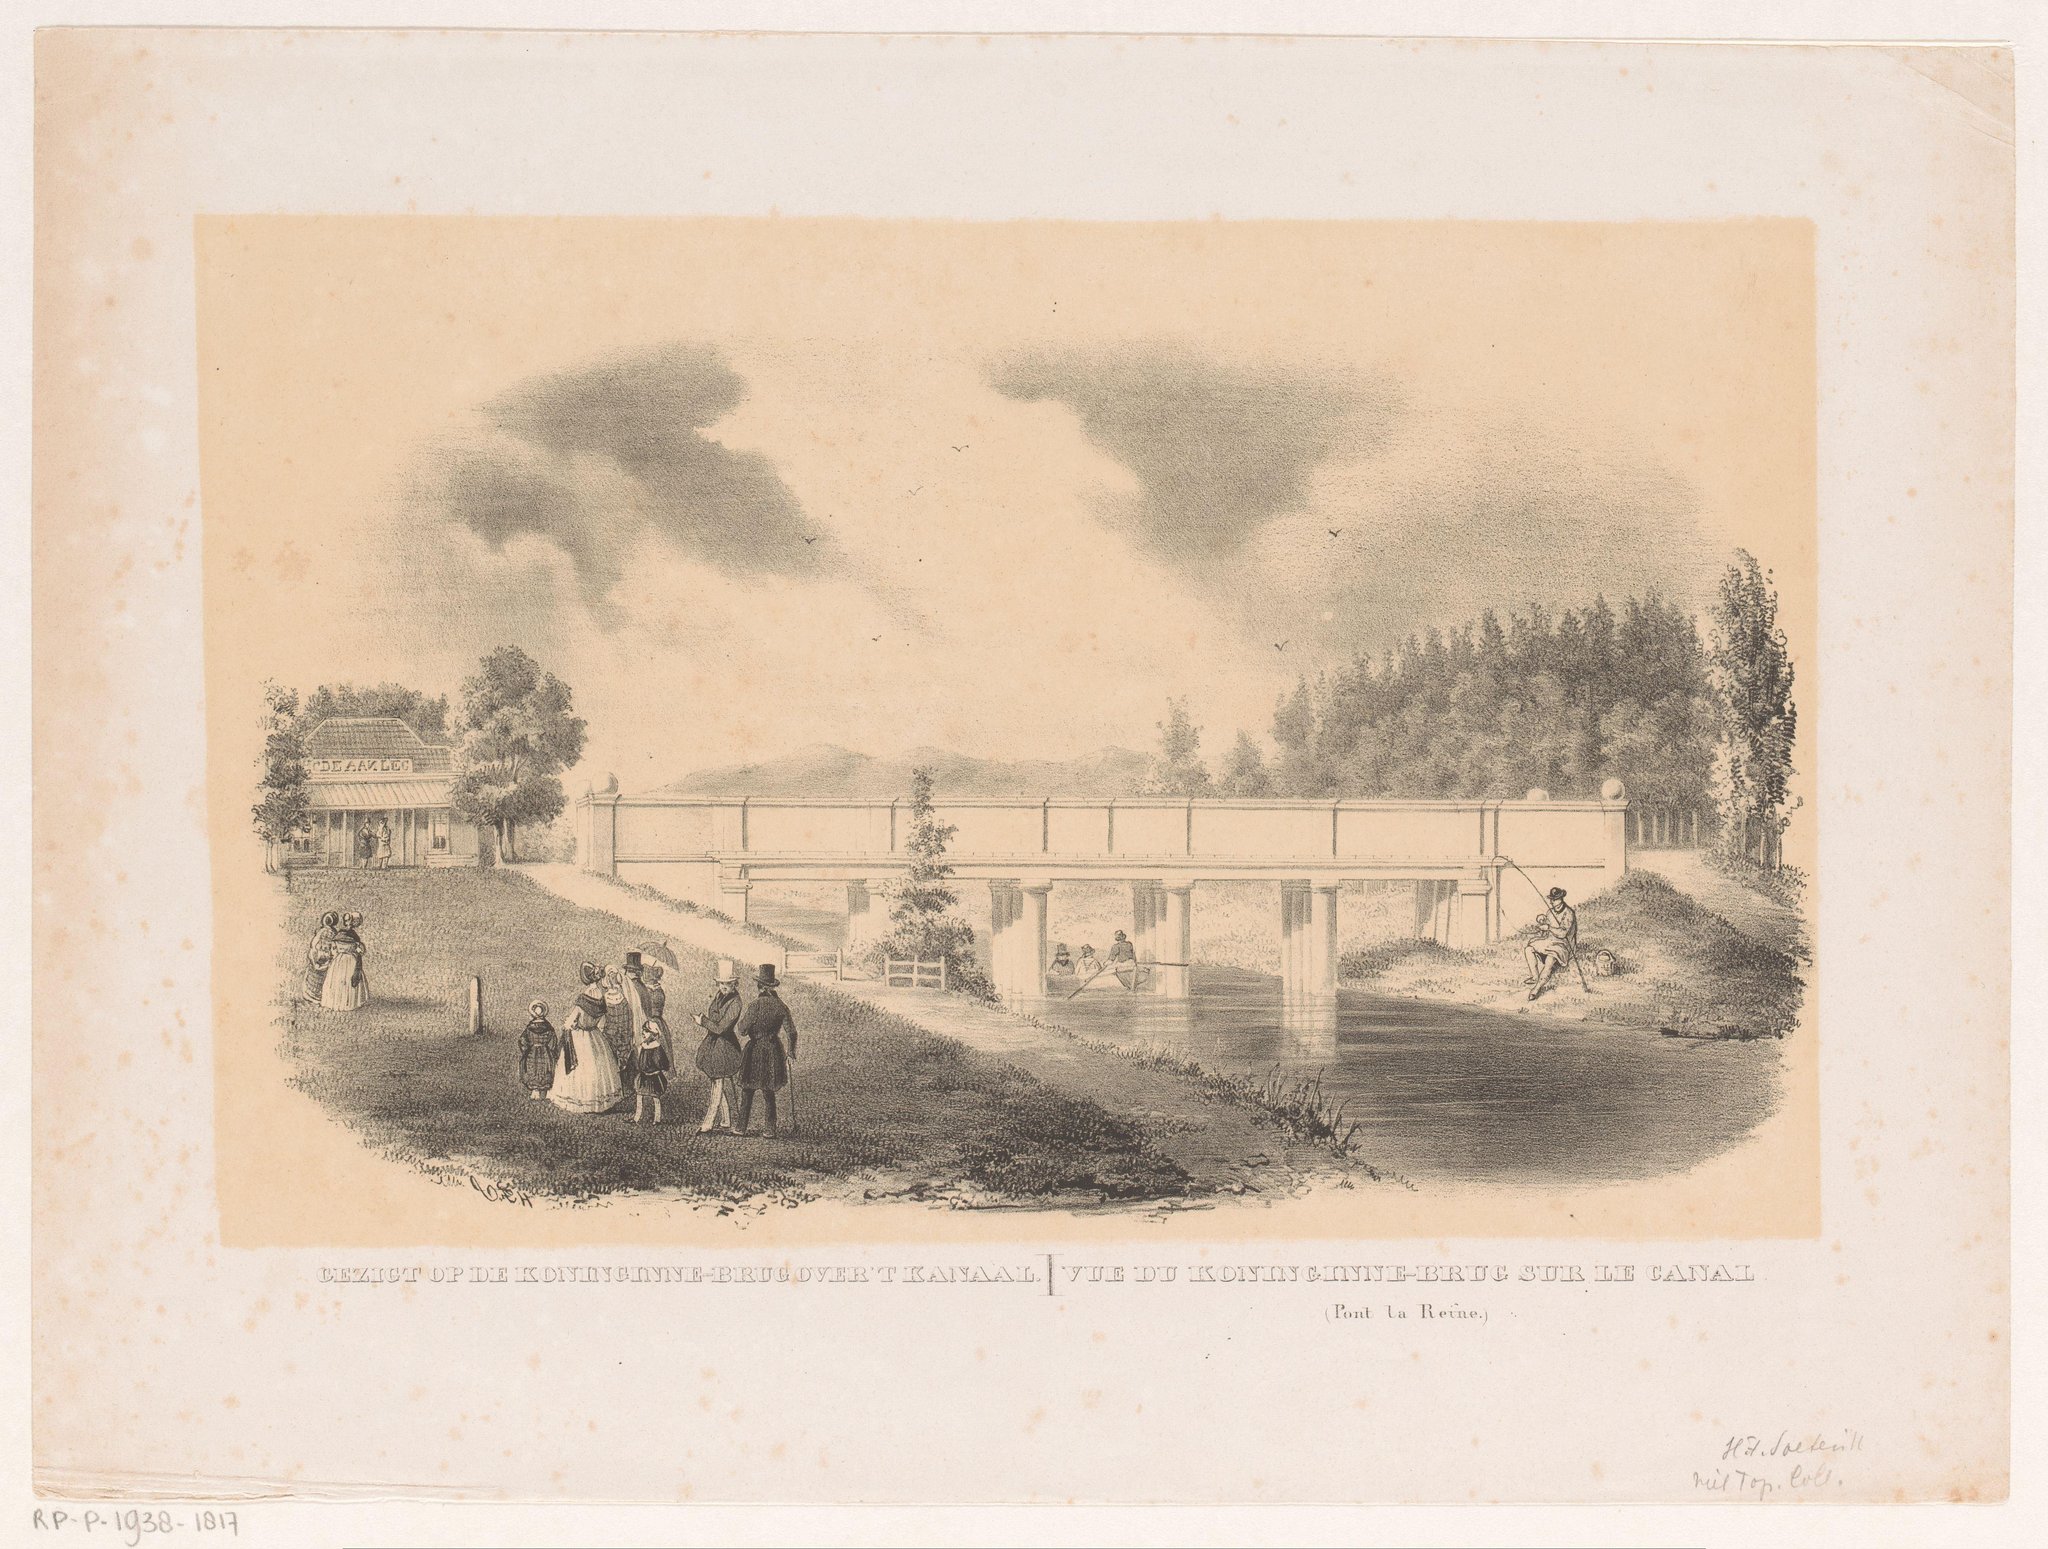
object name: print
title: Gezigt op de Koninginne-brug over 't kanaal / Vue du Koninginne-Brug sur le canal (Pont la Reine)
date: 1830-1846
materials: paper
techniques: tone lithography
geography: the hague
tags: bridge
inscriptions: collector's mark: Lugt 2228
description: Op de oevers van het kanaal in het voormalige gehucht Wittebrug met de Koninginnebrug recreërende mensen en een visser. Op het kanaal vaart een roeiboot. Tegenwoordig is de Witte Brug hier gelegen.